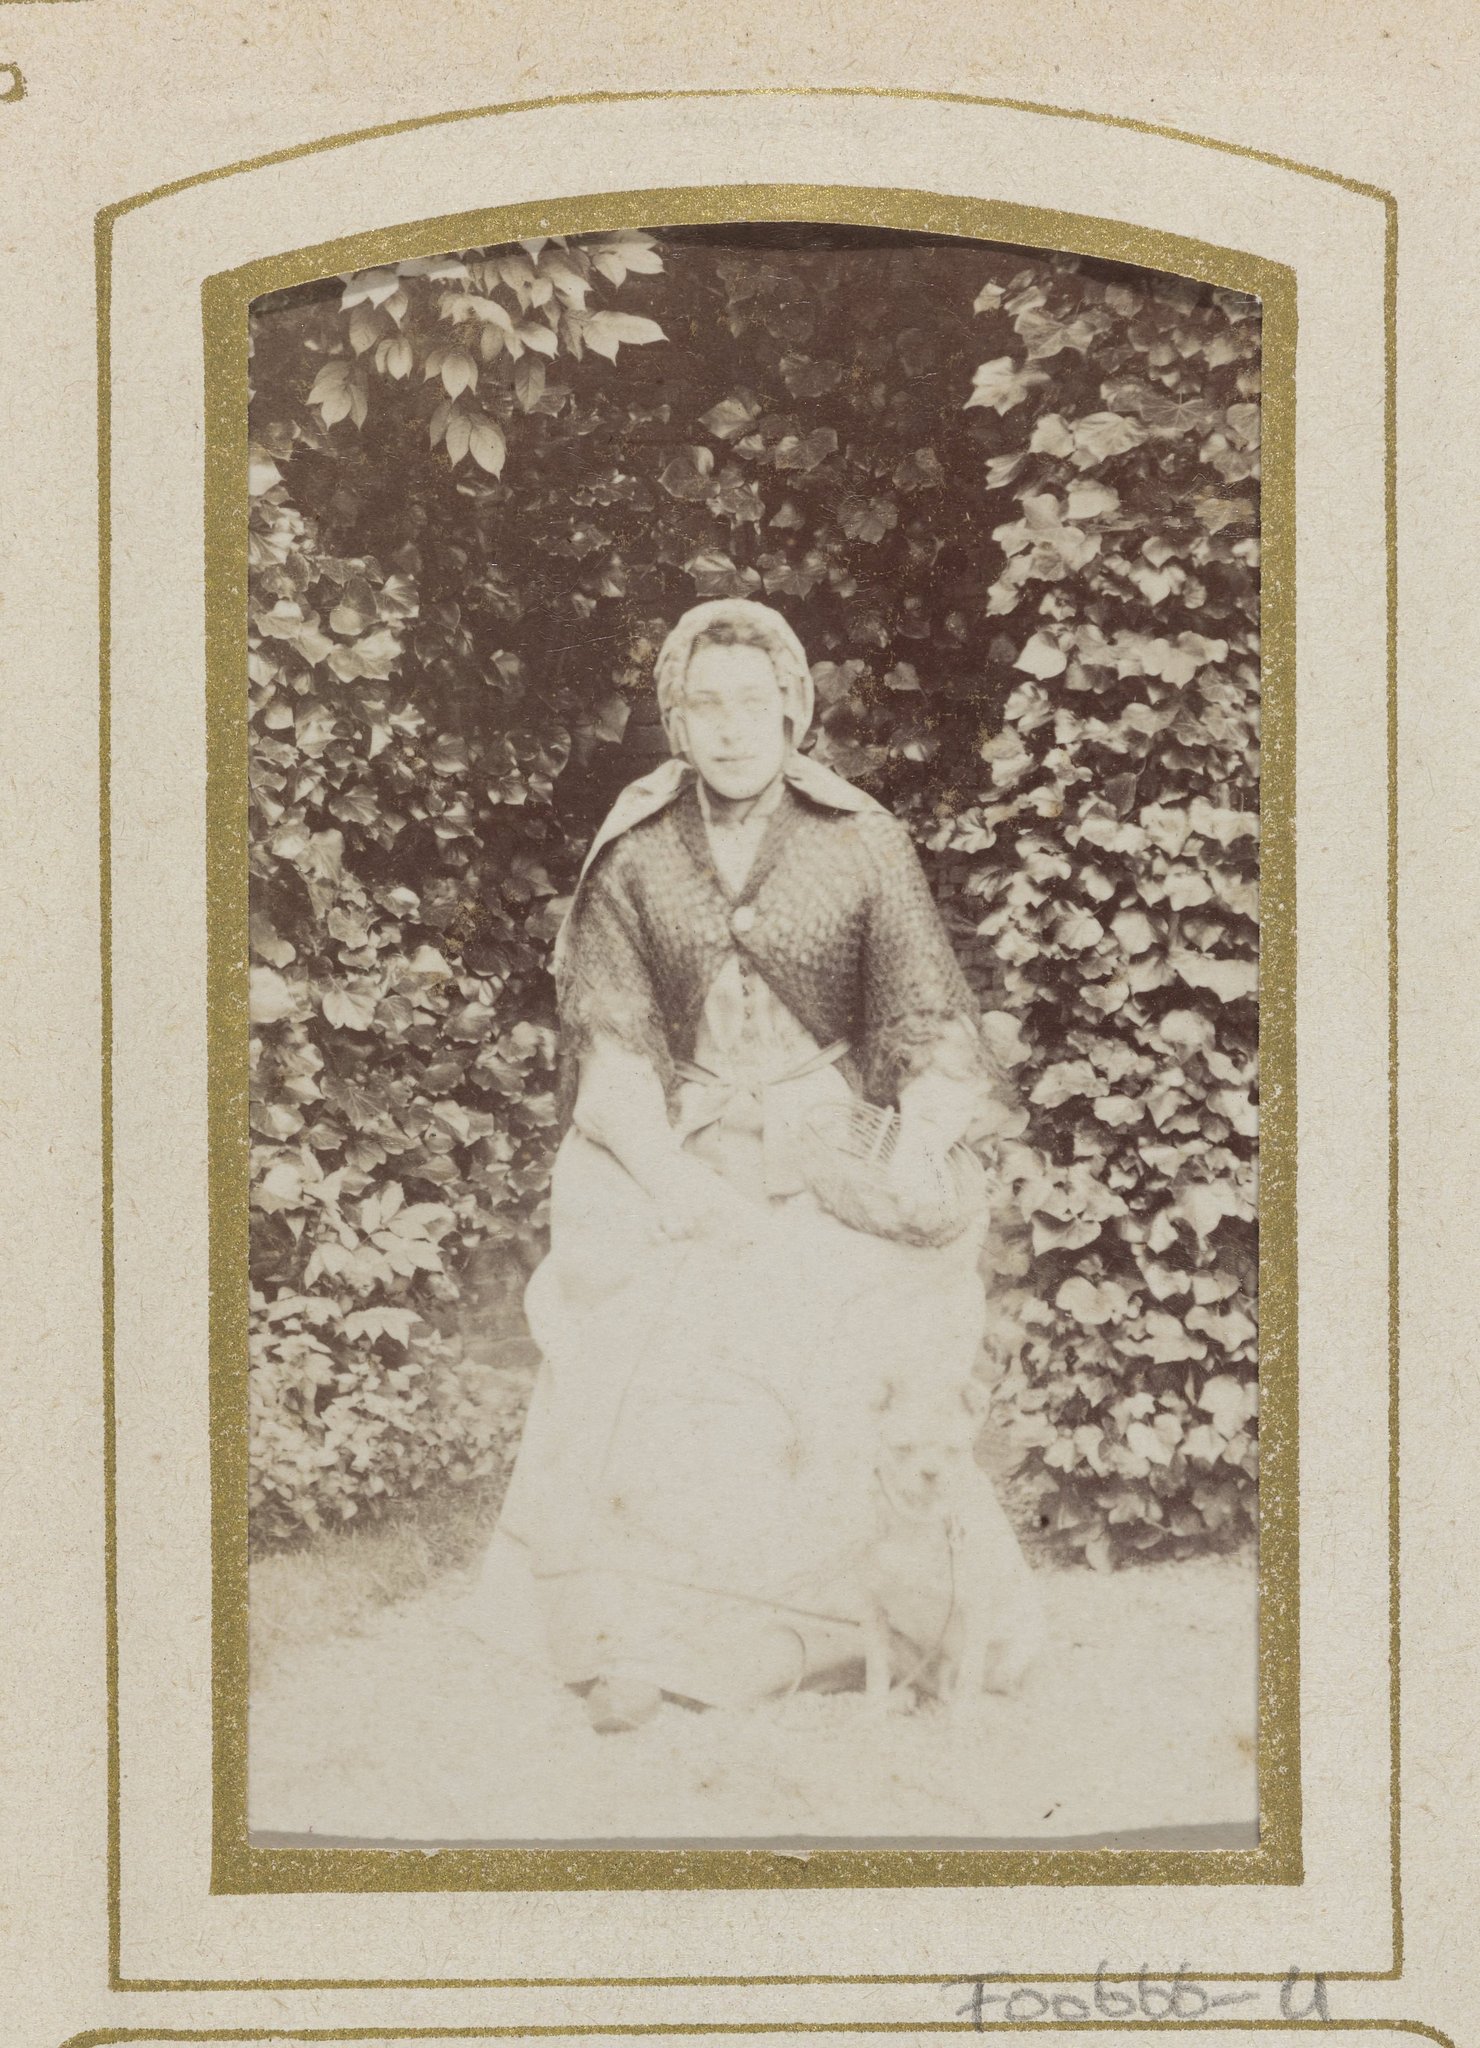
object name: album leaf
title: Portret van een vrouw met een mand in de hand en een hond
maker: Anonymous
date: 1850-1900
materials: cardboard, photographic support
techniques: albumen print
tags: historical persons - bb - woman, container made of plant material other than wood: basket, dog